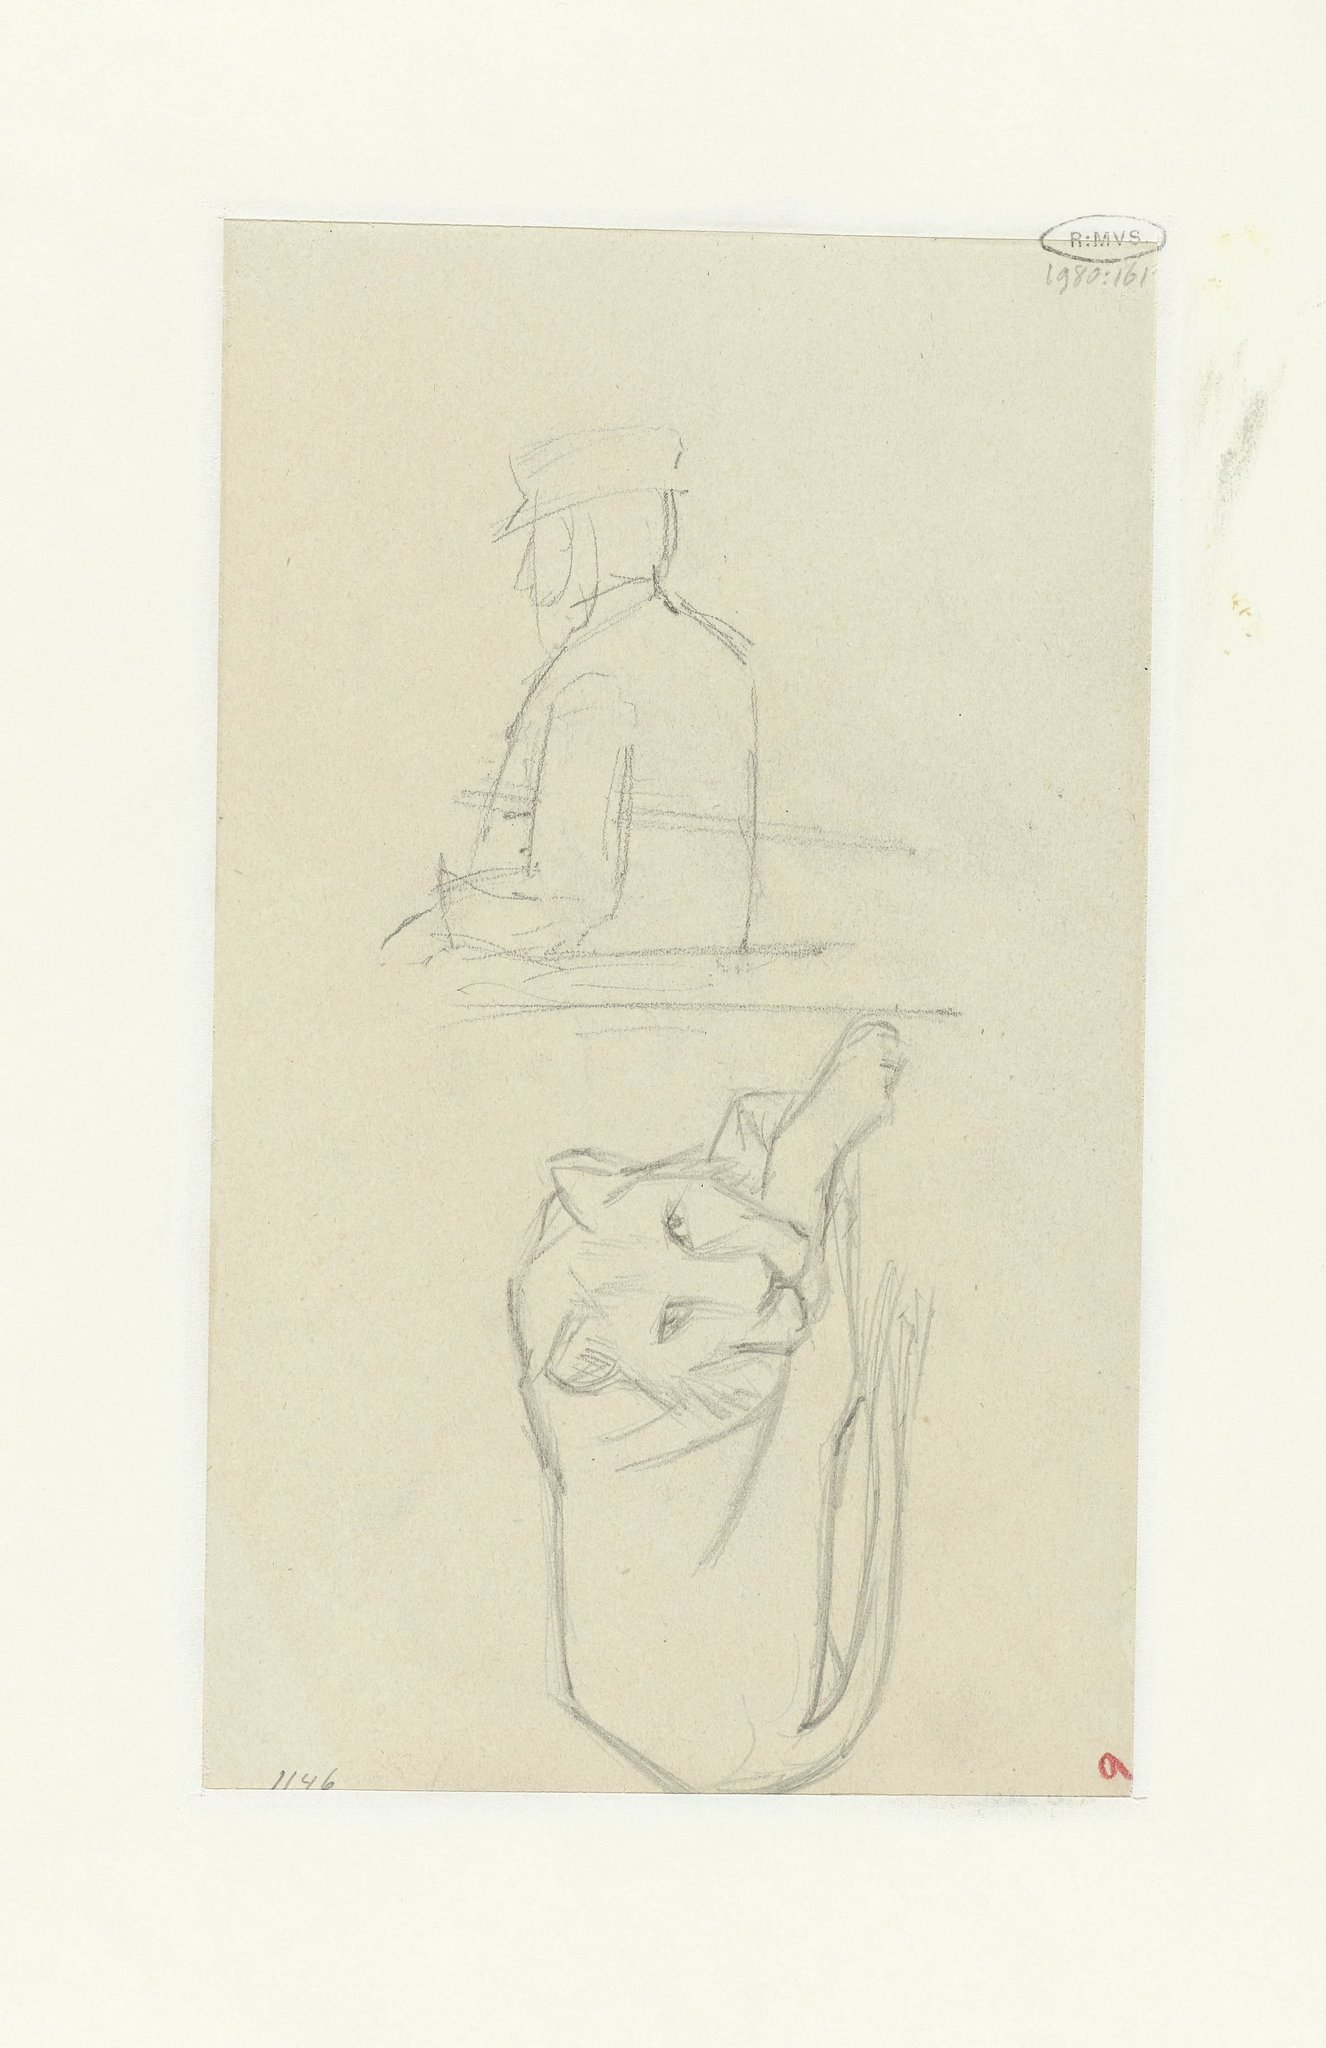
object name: drawing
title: Leeuw en een man met een pet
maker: jozef israëls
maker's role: draughtsman, painter, print maker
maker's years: 1824-1911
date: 1834-1911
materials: paper, pencil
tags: beasts of prey, predatory animals: lion